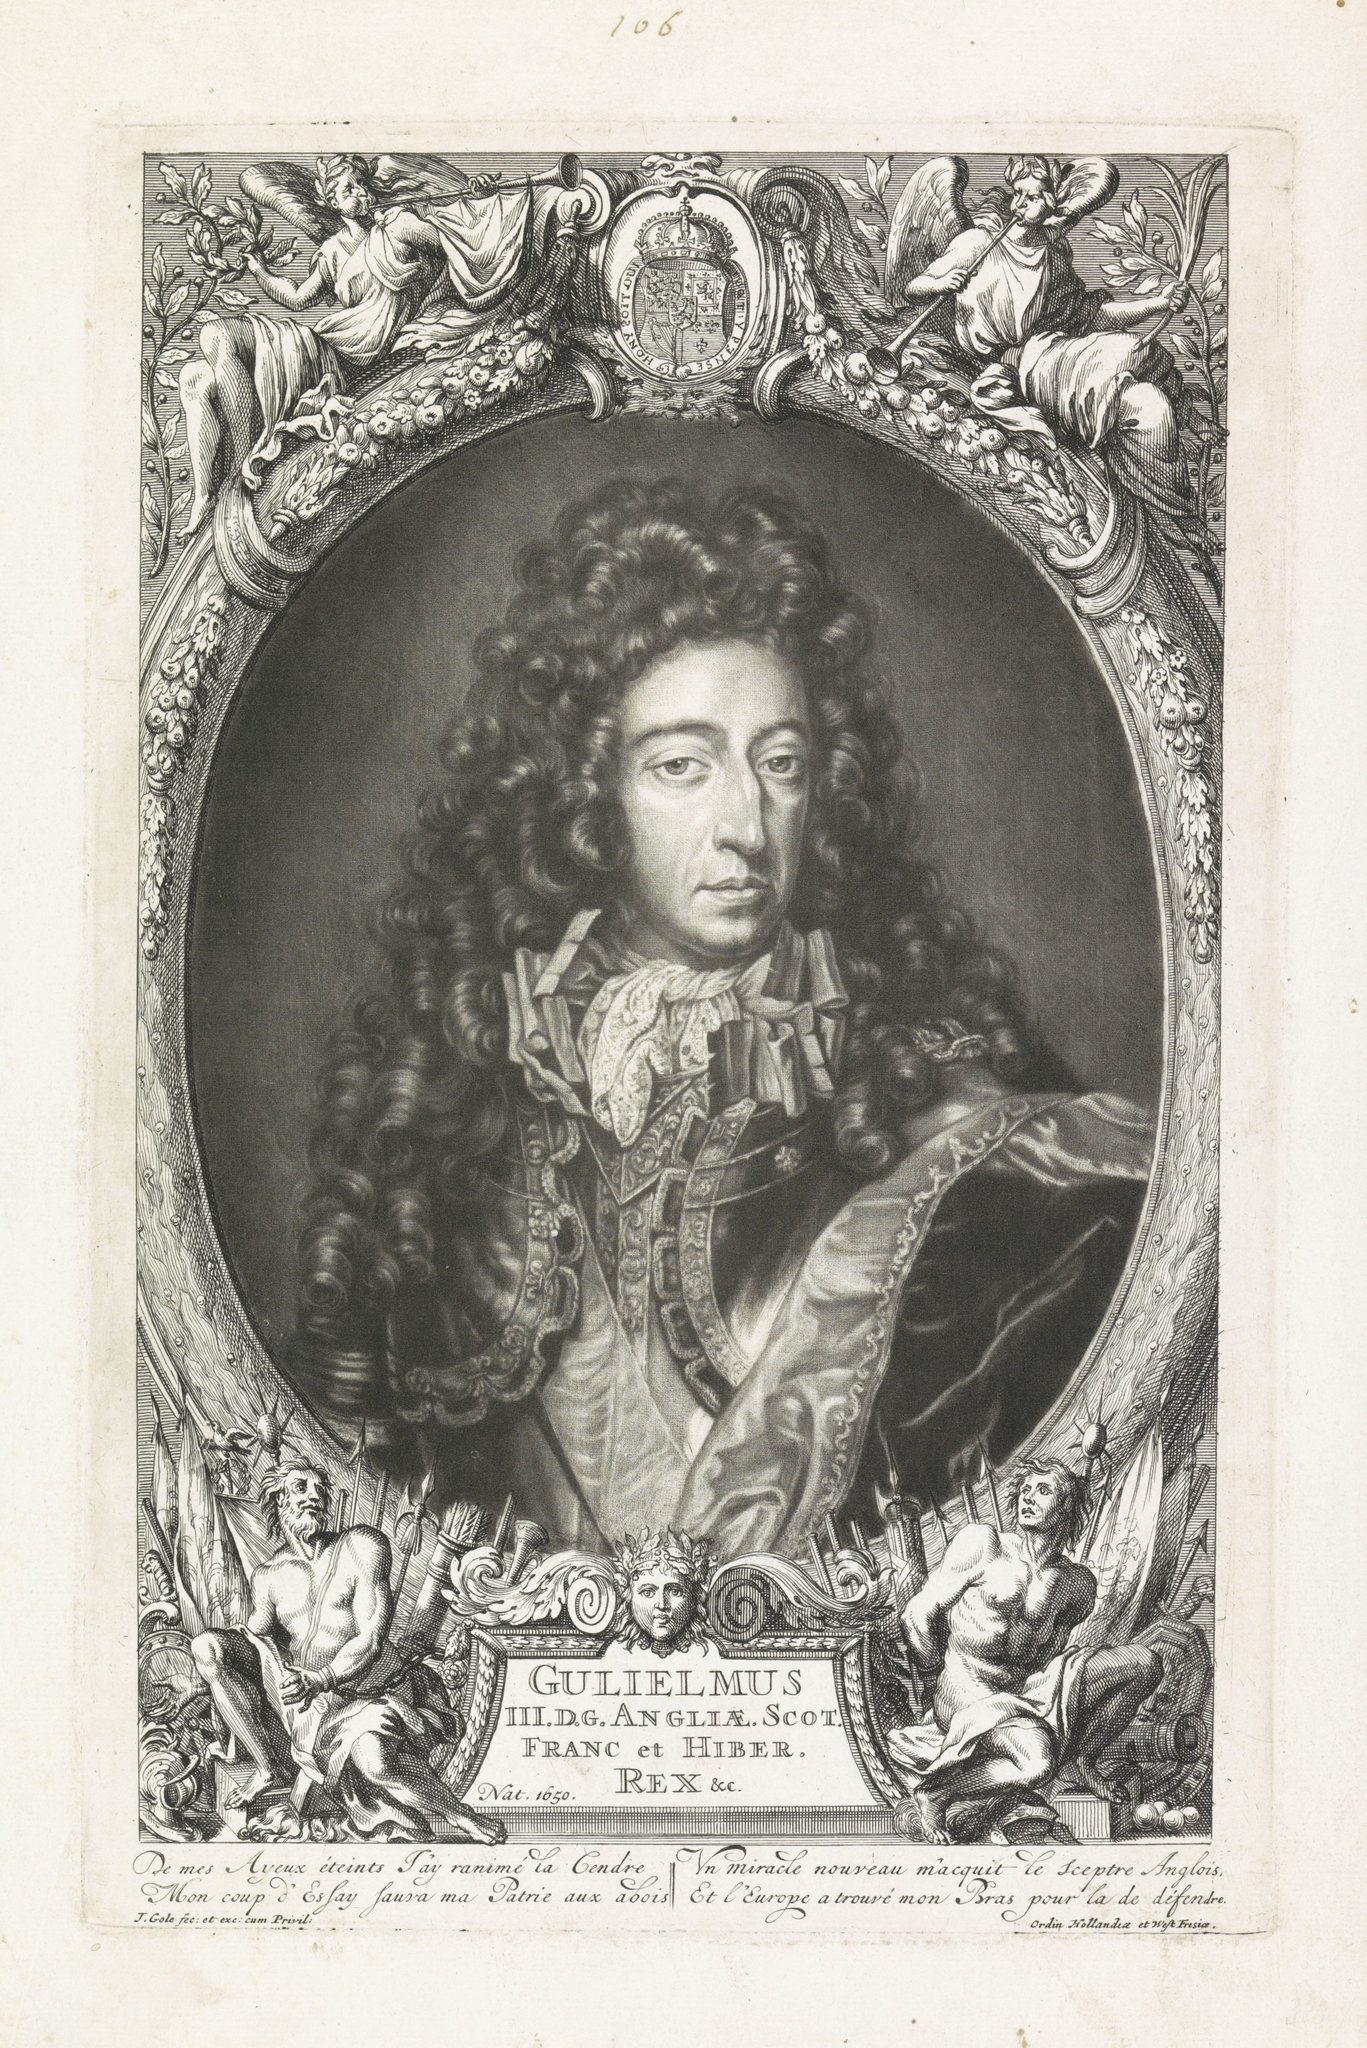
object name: print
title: Portret van Willem III, prins van Oranje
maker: jacob gole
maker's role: print maker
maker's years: 1660-1724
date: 1688-1724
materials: paper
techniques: etching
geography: amsterdam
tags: the hague, william iii (prince of orange and king of england, scotland, and ireland), knighthood order (garter) - insignia of a knighthood order, e.g.: badge, chain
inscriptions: collector's mark: Lugt 2228, collector's mark: Lugt 2760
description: Portret van Willem III in een ovaal van lauwerbladen en oranjetakken. Daar omheen een aantal allegorische objecten en figuren. Midden boven zijn wapen met een kroon, gedecoreerd met de Kousenband en het devies van de Orde van de Kousenband. Op een voetstuk zijn geboortejaar en zijn naam en titels. In de ondermarge twee kolommen met elk twee regels Franse tekst.